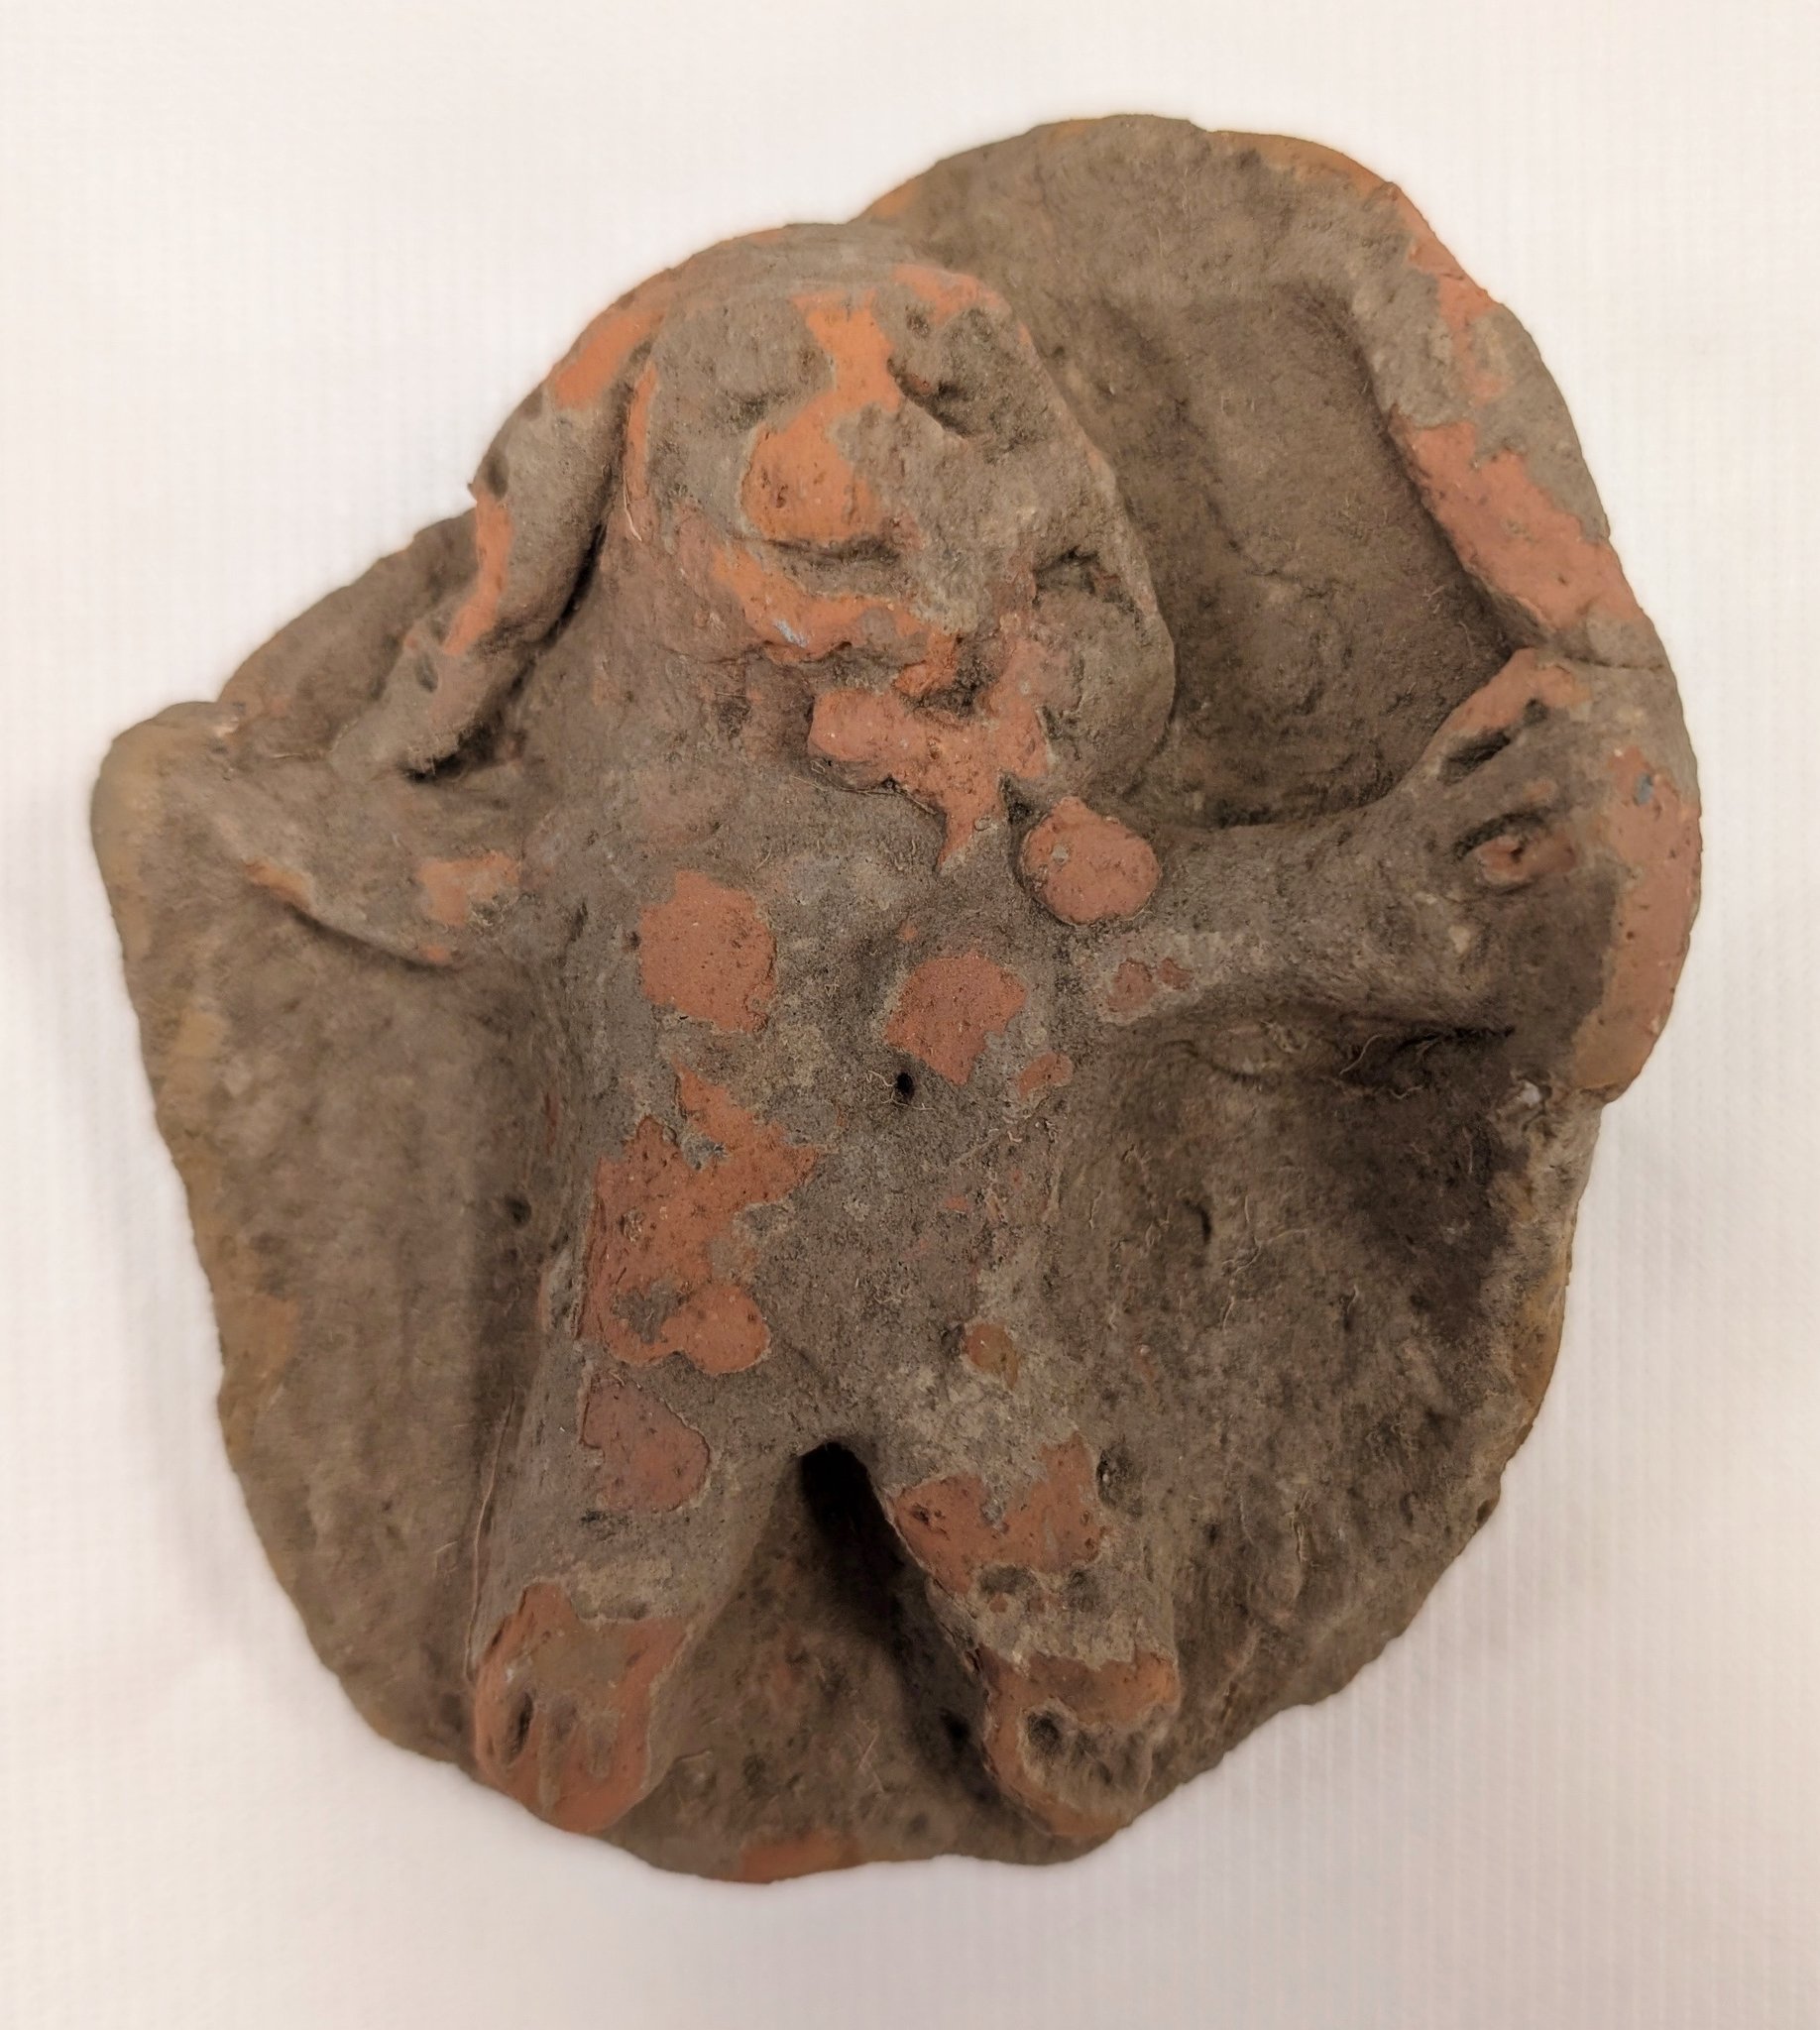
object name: plaque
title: Plaque in the Form of a Standing Female Figure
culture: pakistani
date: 101-300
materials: terracotta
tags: gandhara